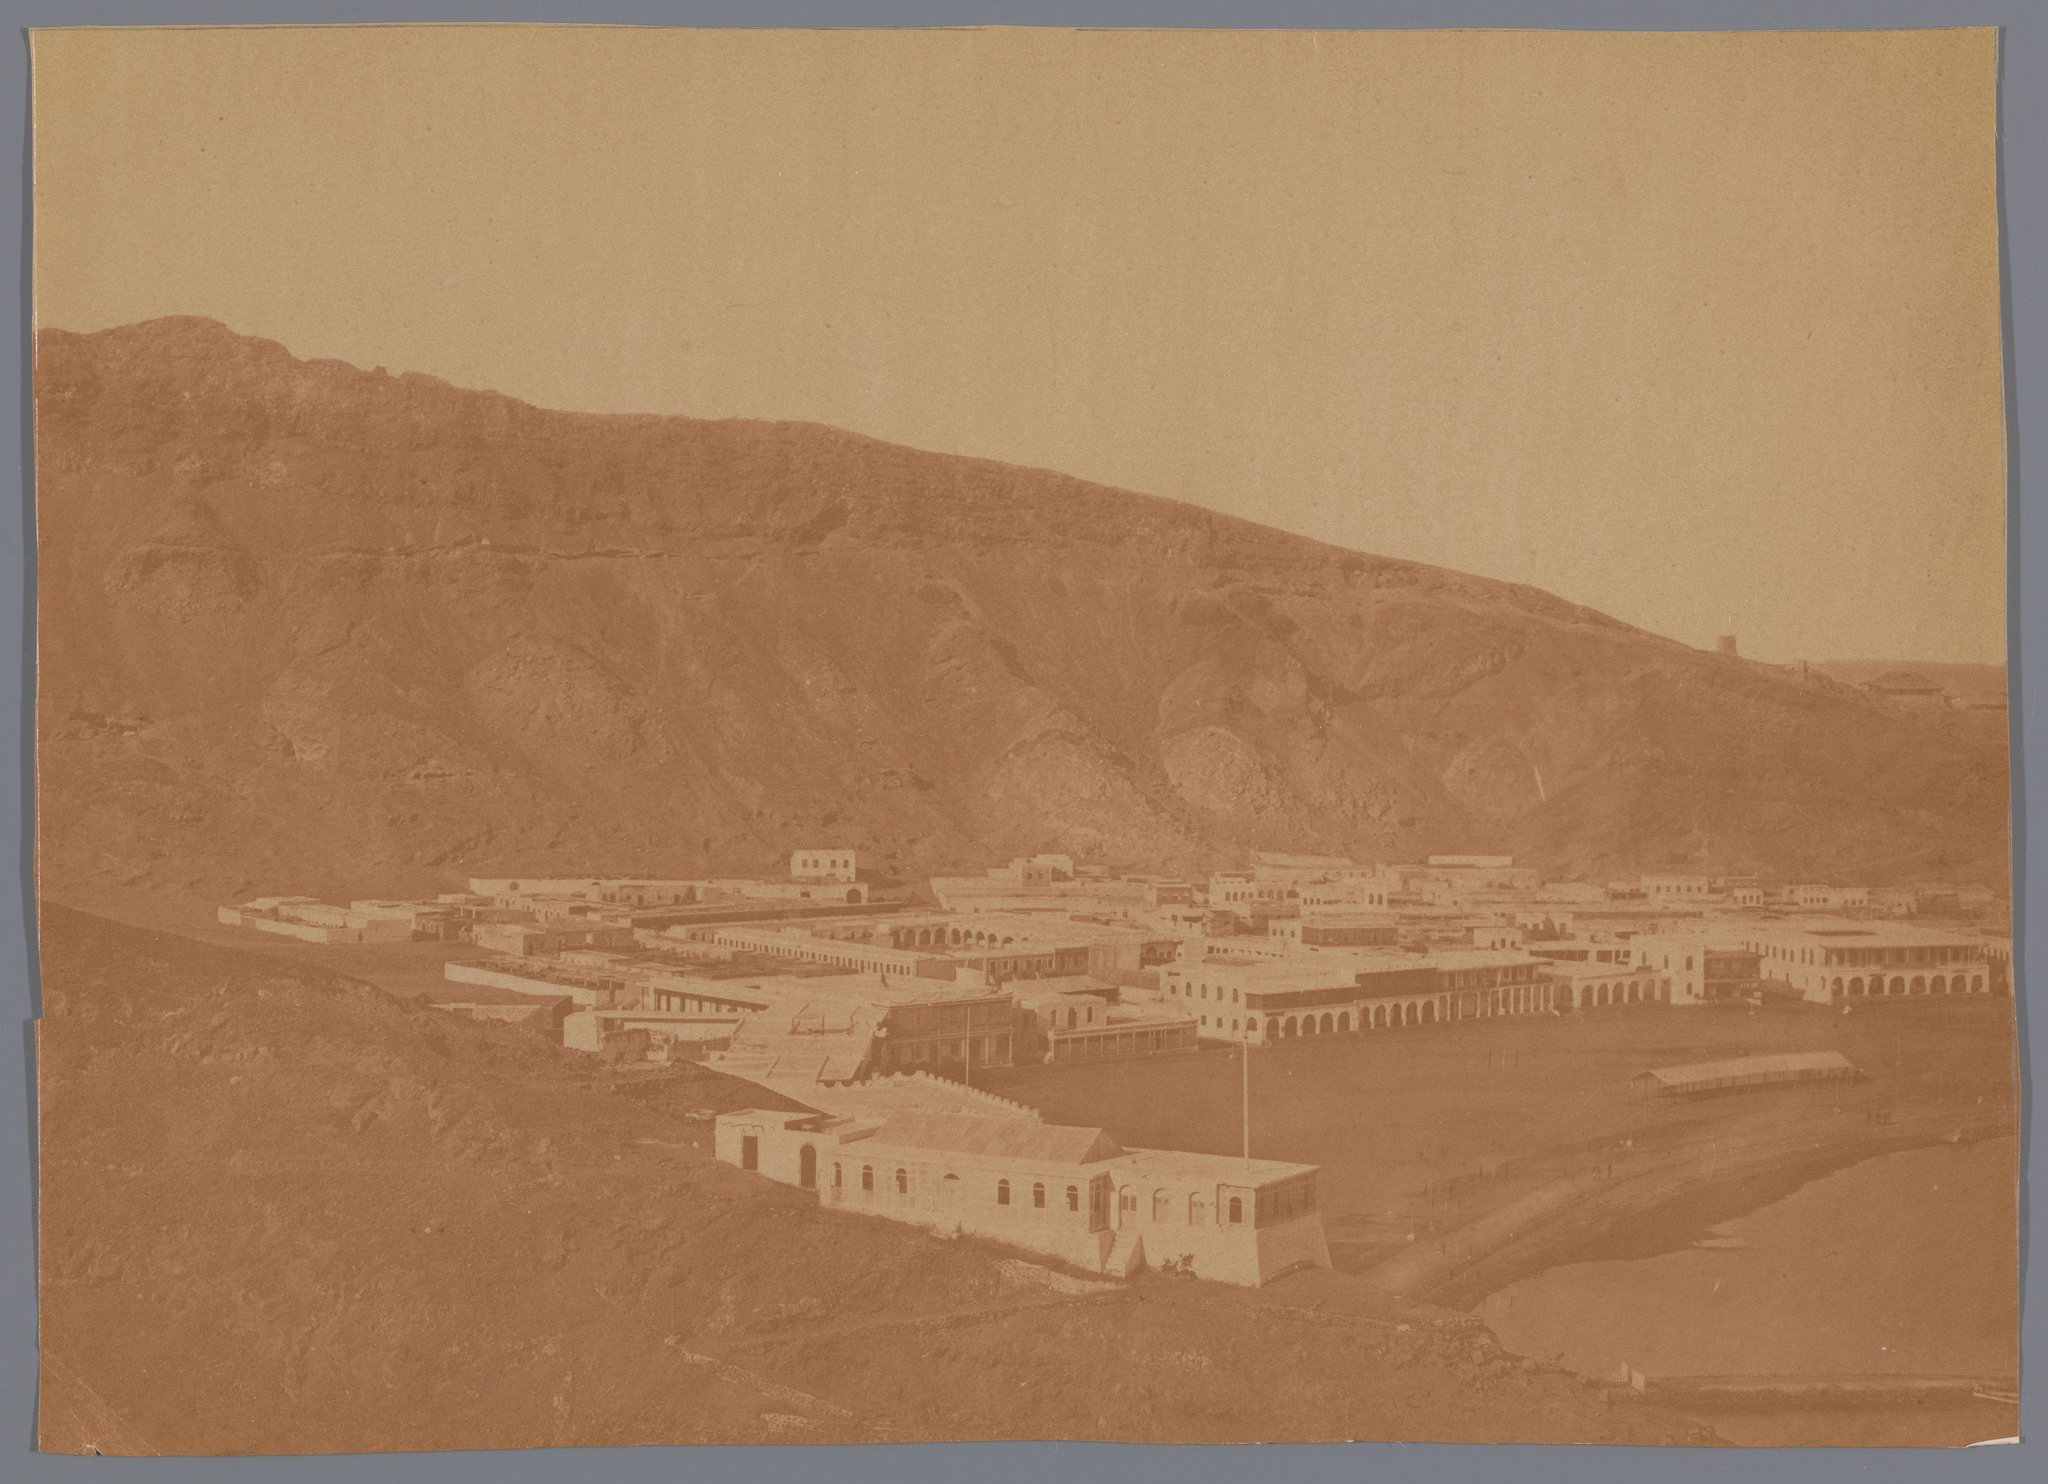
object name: photograph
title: Gezicht op de kust van Aden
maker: Anonymous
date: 1851-1900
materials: paper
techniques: albumen print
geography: aden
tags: coast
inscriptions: inscription: ‘Aden’